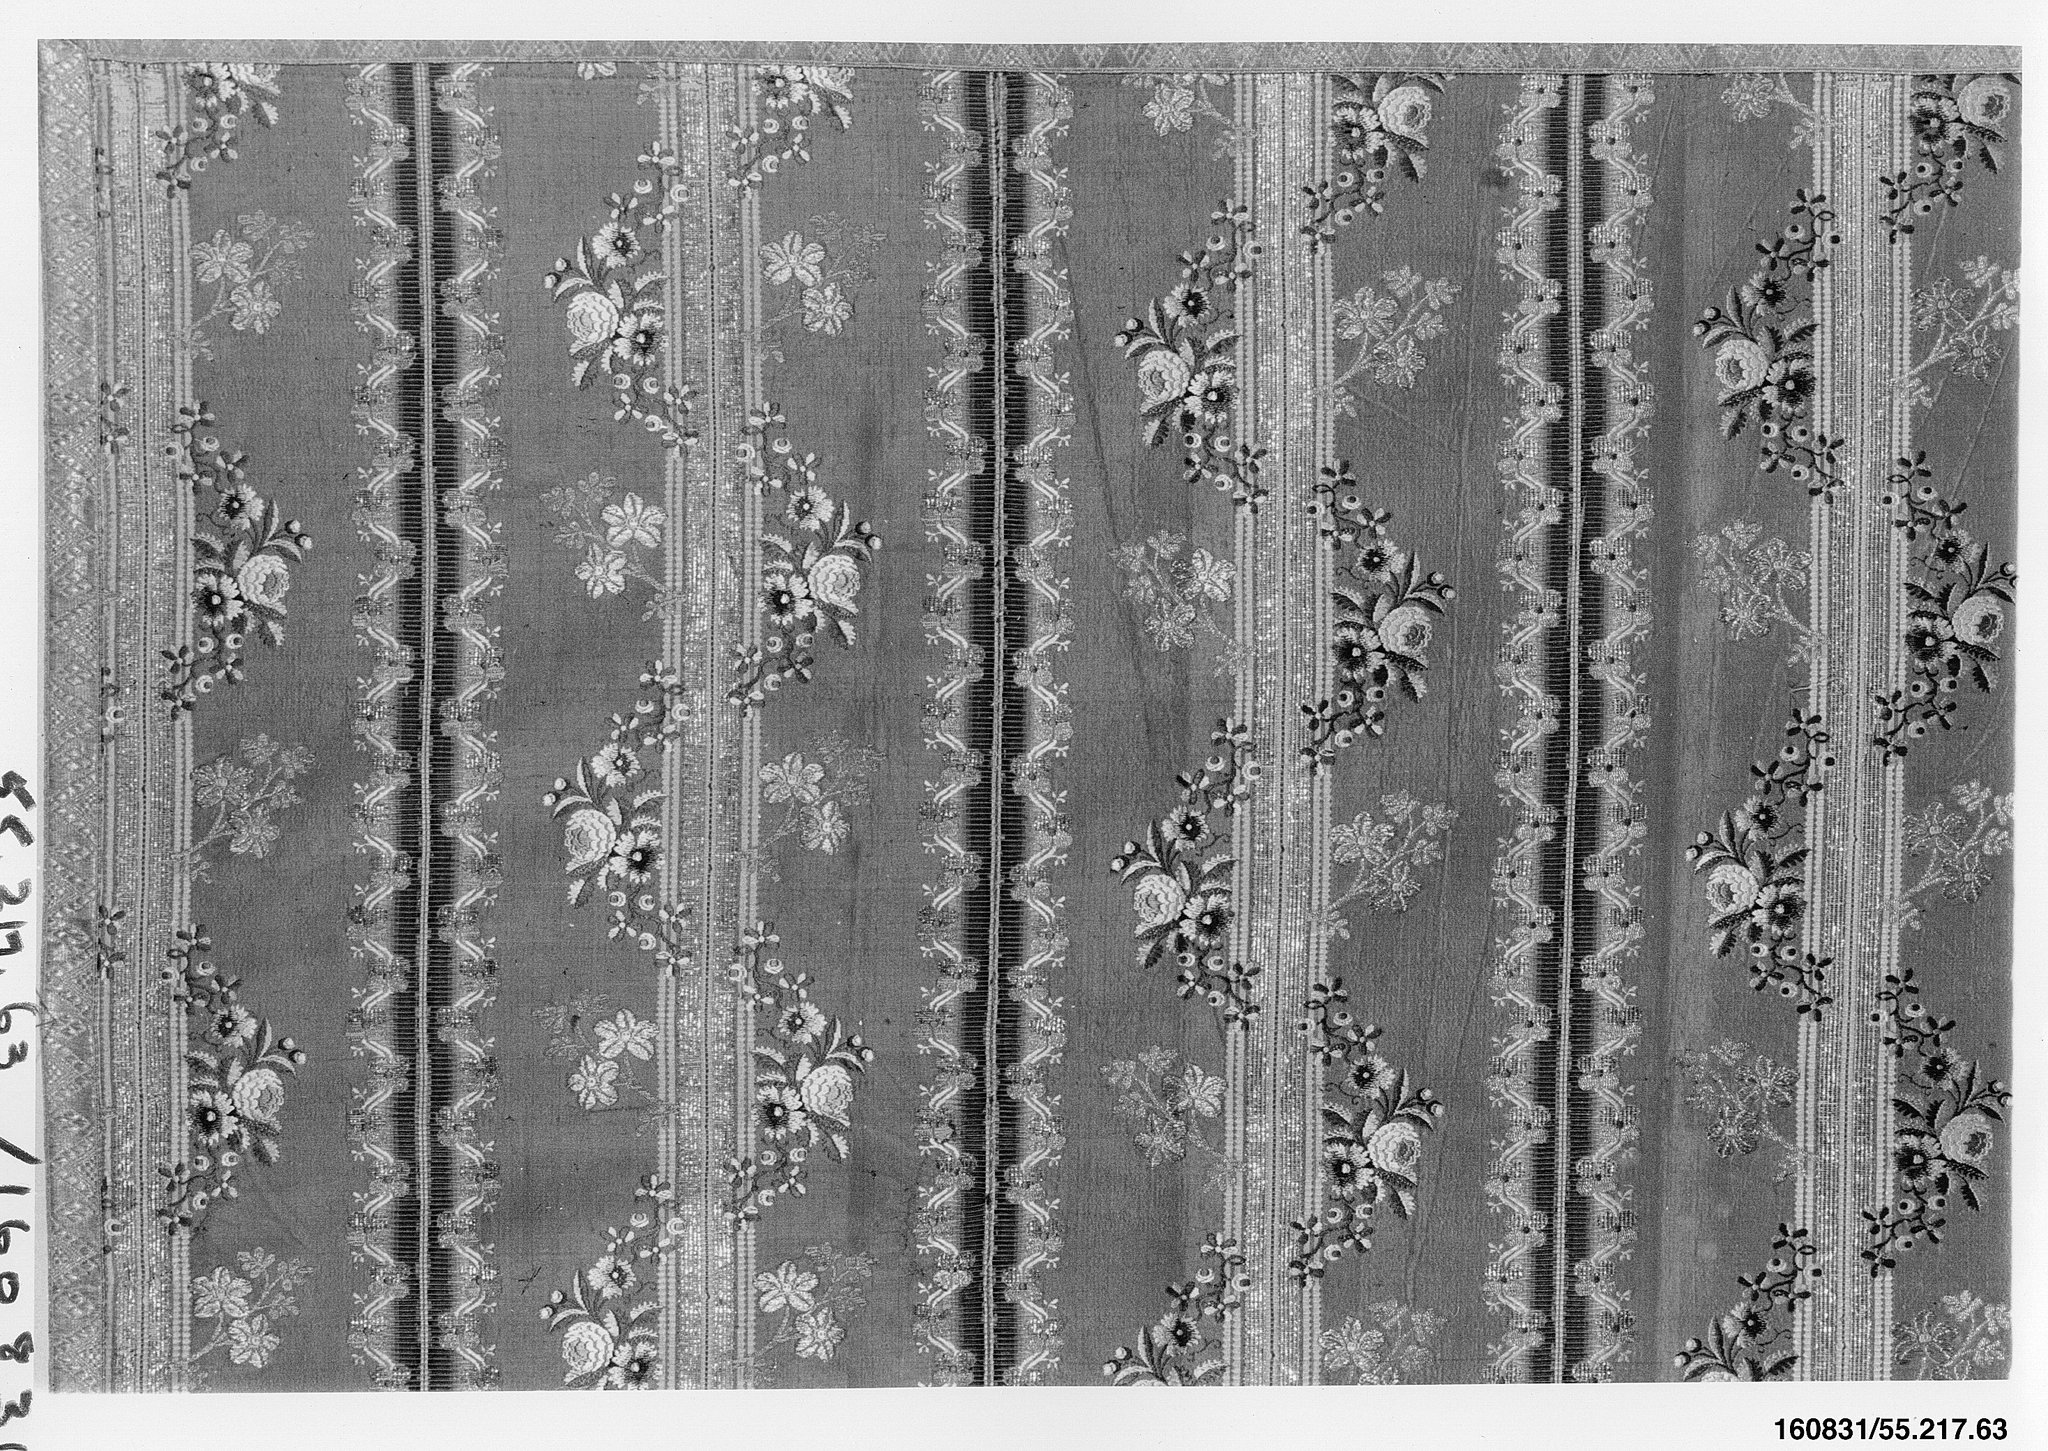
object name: piece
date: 1767-1800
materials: metal thread, silk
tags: flowers